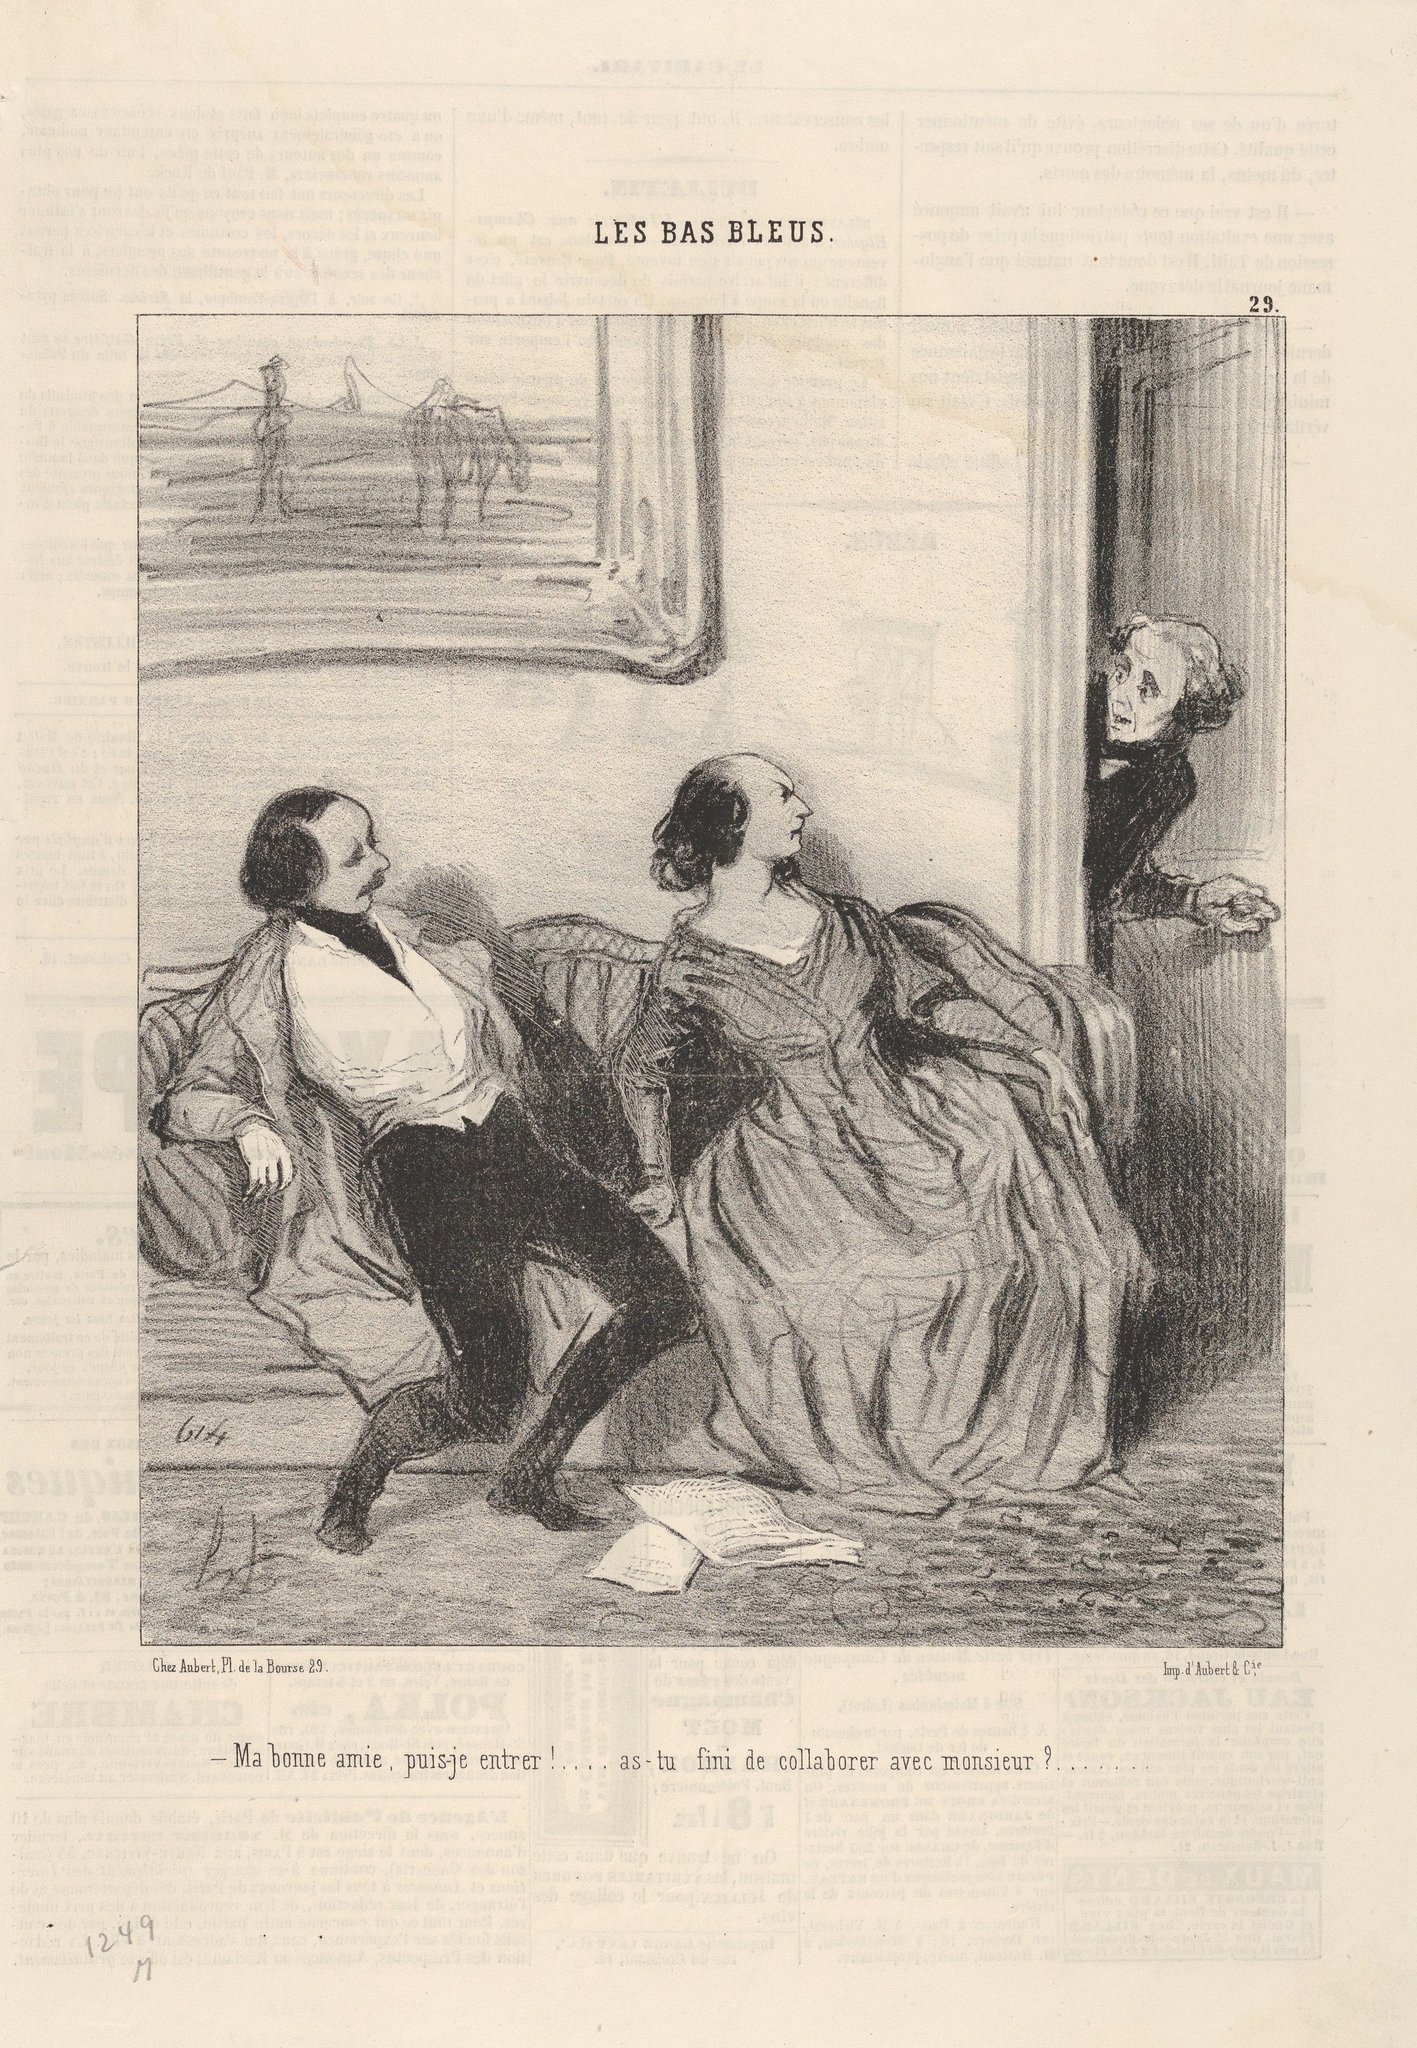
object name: print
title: May I come in my dear, or are you still collaborating with Monsieur?, plate 29 from "The Bluestockings"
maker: honoré daumier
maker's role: artist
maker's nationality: french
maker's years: 1808-1879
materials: paper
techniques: lithograph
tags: men,women